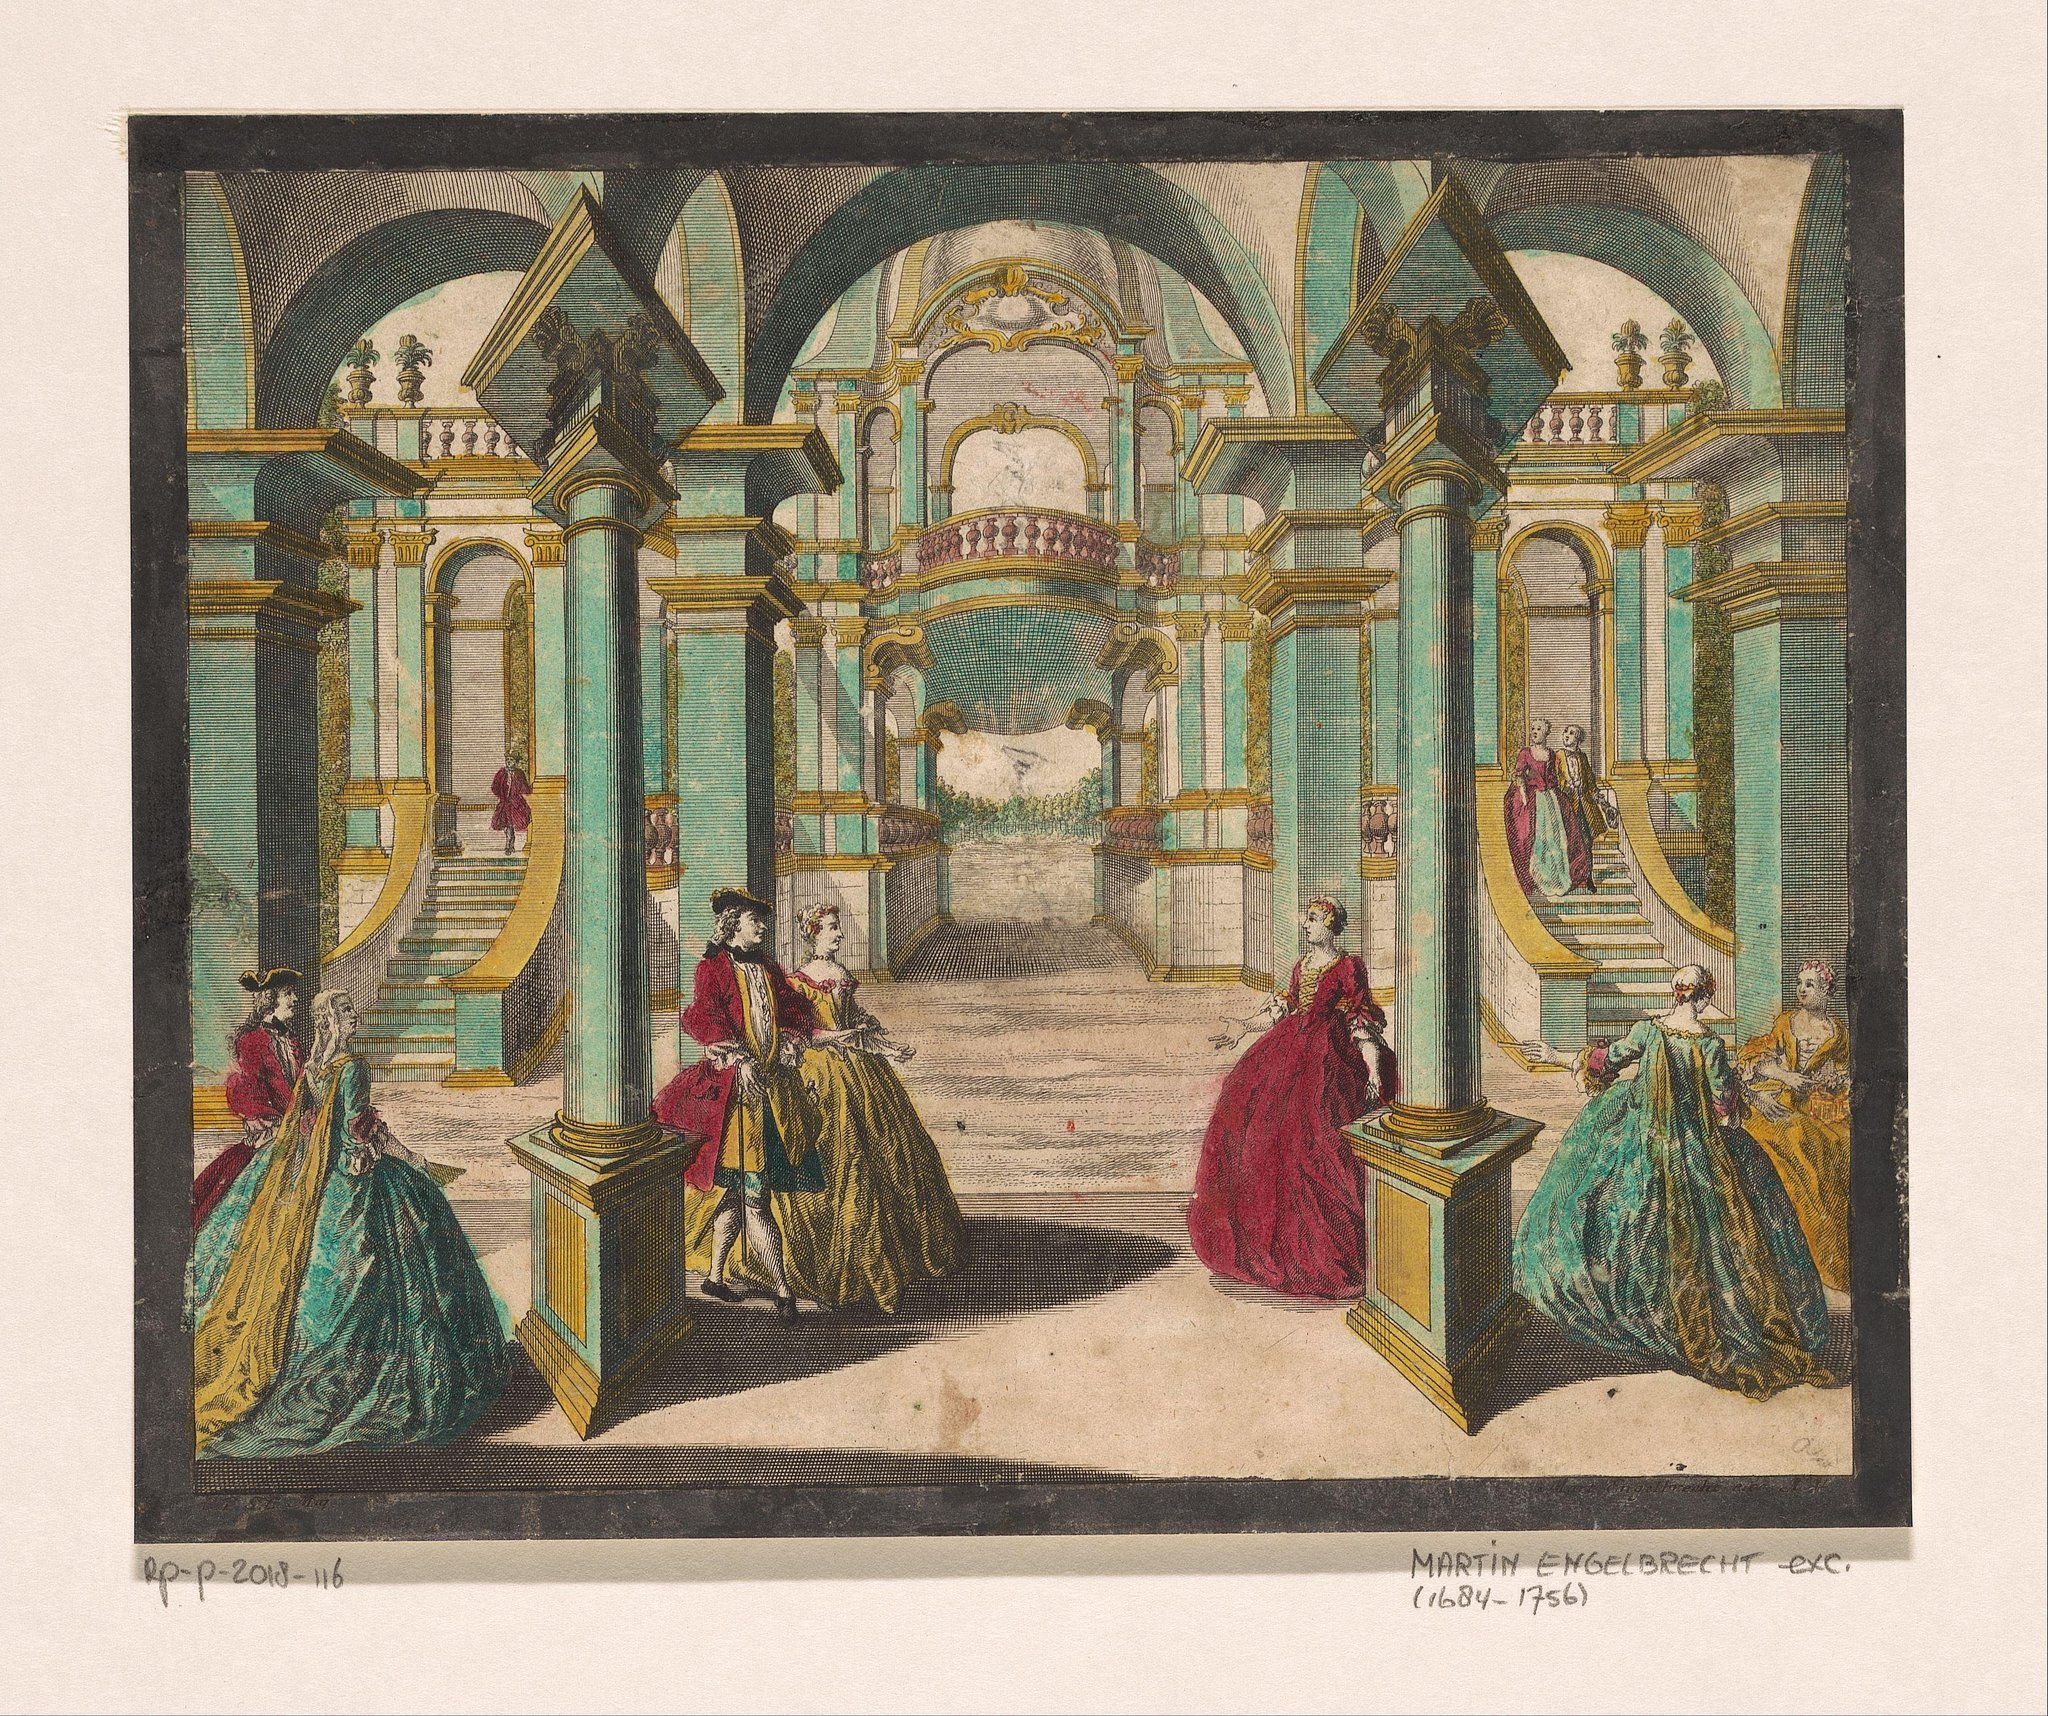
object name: print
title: Gezicht op het interieur van een paleis, met verscheidene rijk geklede dames en heren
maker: martin engelbrecht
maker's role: print maker, publisher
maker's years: 1684-1756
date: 1684-1756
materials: paper, watercolor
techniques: engraving, etching, hand coloring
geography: augsburg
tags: architectural detail, interior of the house, 'perspective' (alleg.); 'prospetiva' (ripa)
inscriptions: collector's mark: Lugt 2228